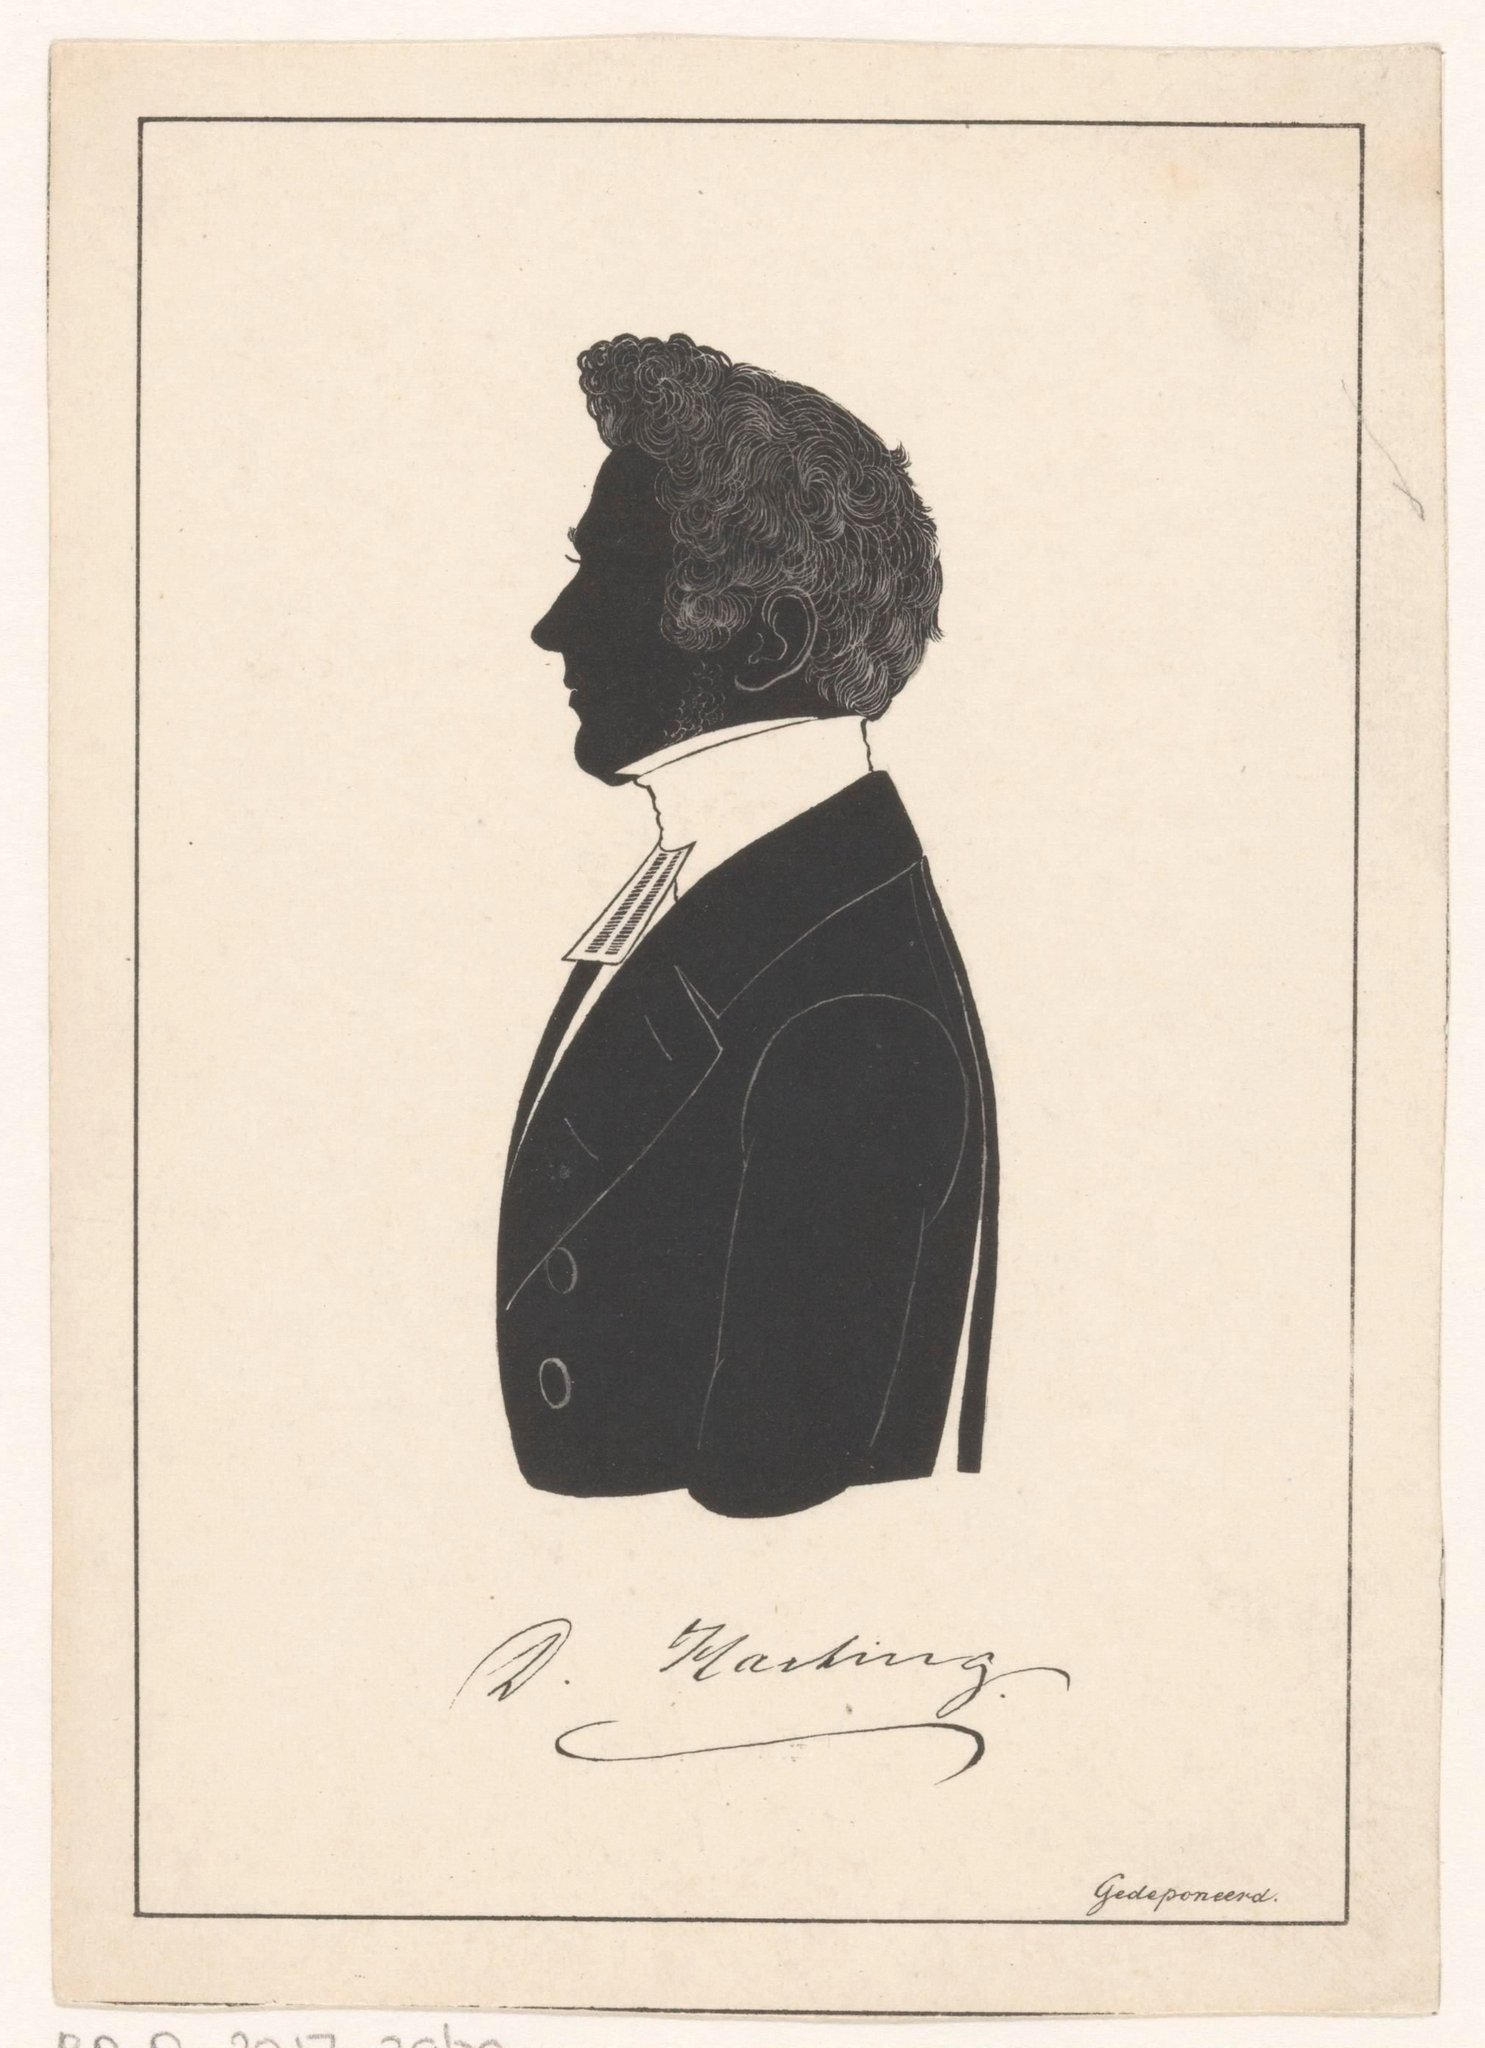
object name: print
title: Silhouetportret van Dirk Harting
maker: pieter barbiers (iv)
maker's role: painter, print maker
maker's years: 1798-1848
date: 1809-1848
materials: paper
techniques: hand coloring, lithograph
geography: netherlands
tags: enkhuizen, historical persons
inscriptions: collector's mark: Lugt 2228, : ‘Gedeponeerd.’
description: Onder het portret de signatuur van de geportretteerde.